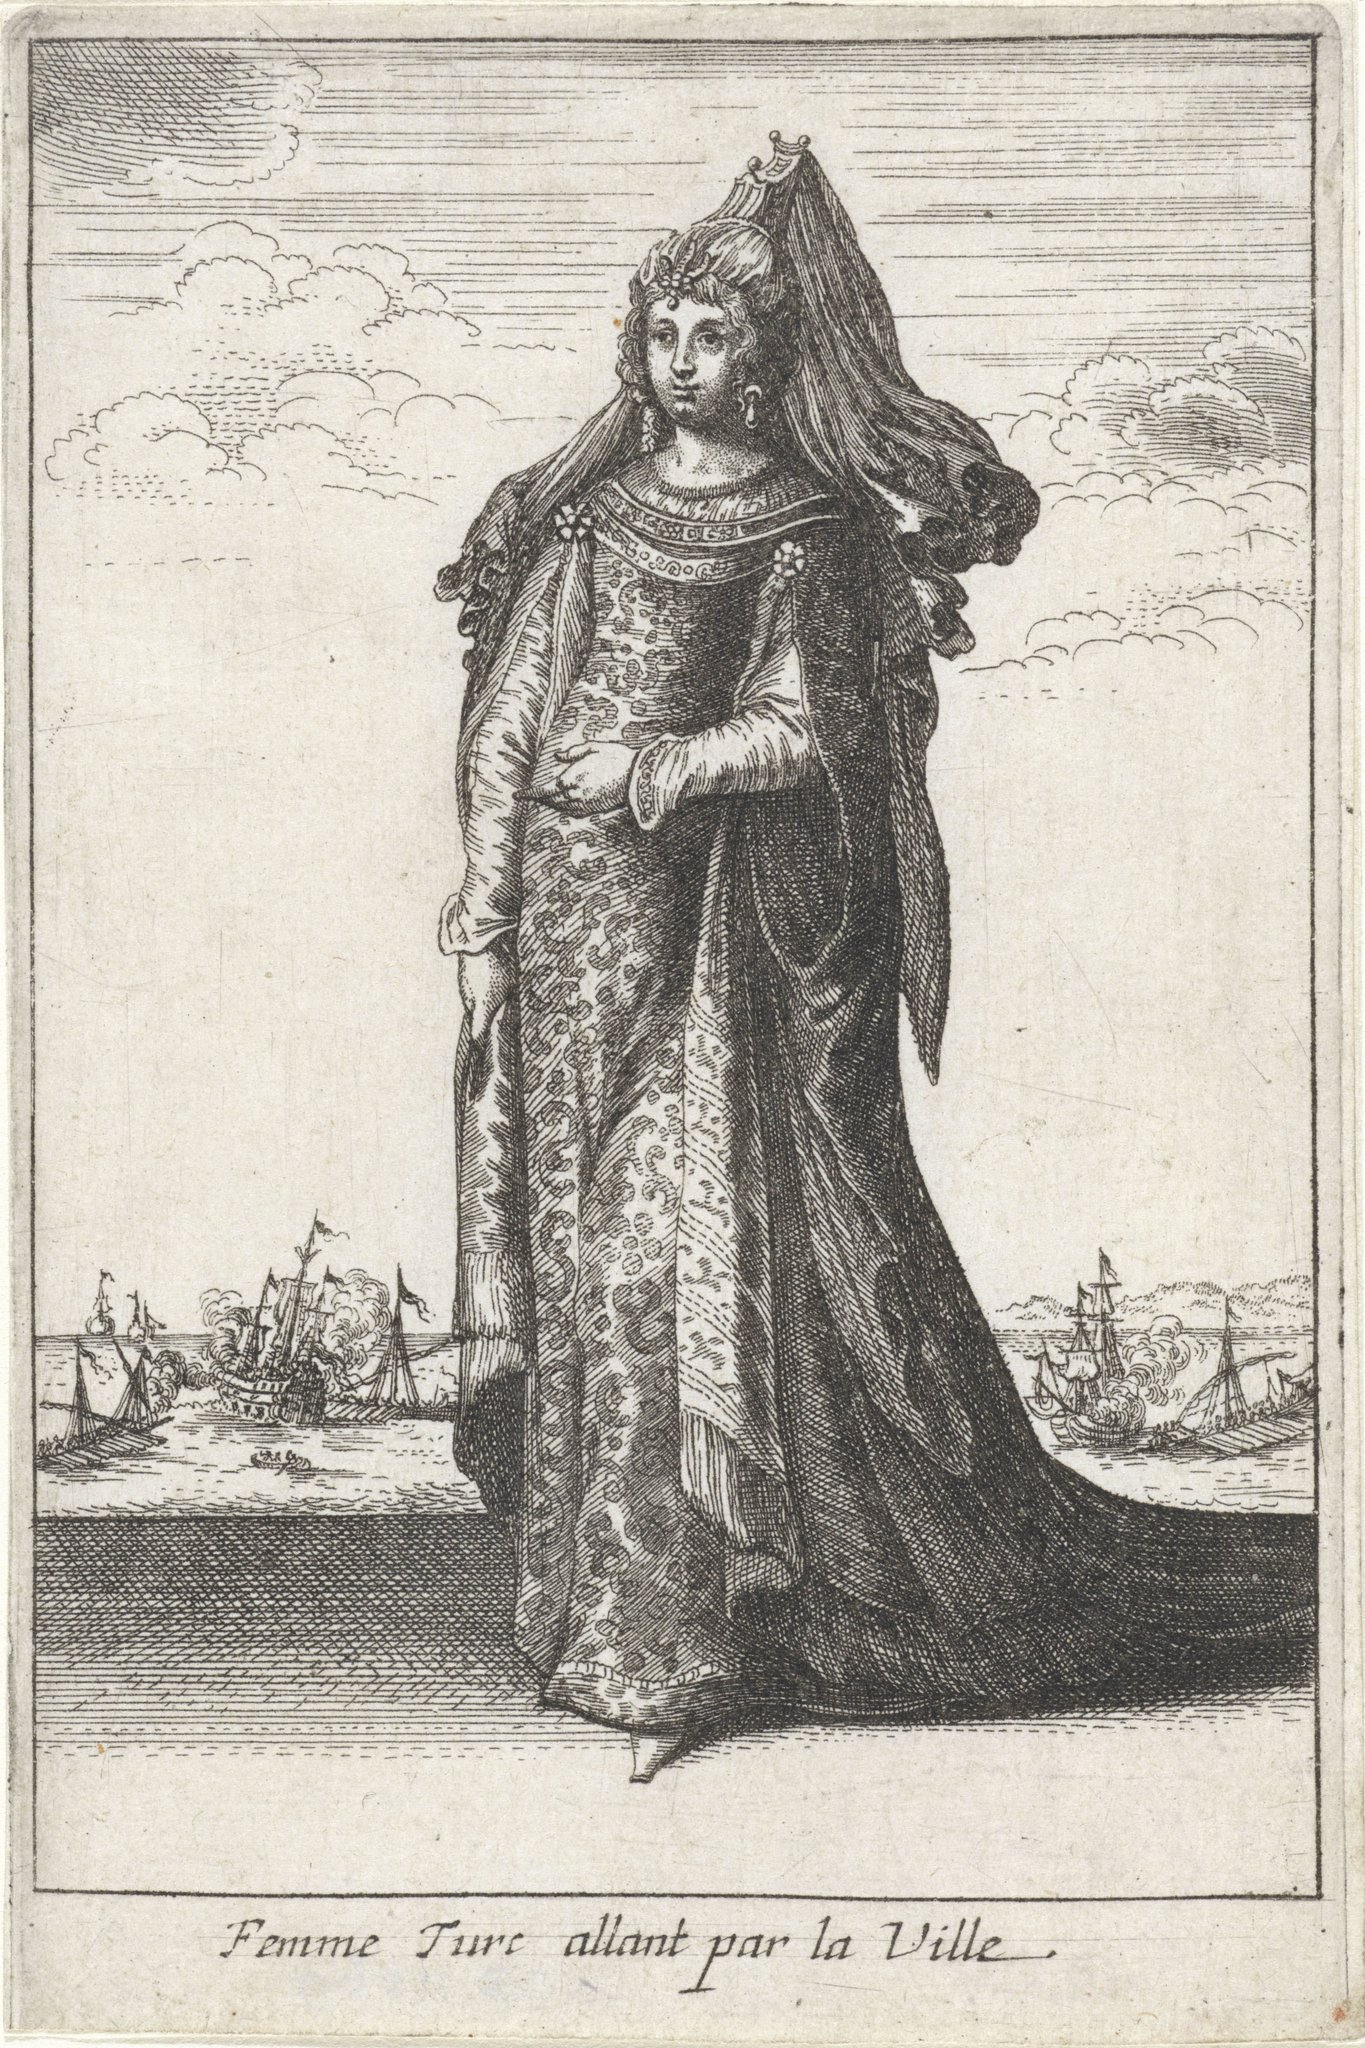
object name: costume print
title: Vrouwen in klederdracht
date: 1662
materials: paper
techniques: etching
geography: paris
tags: turkije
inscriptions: collector's mark: Lugt 240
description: Kopie naar prent die deel uitmaakt van de 50-delige serie met klederdracht van vrouwen uit verschillende landen. De prent maakt deel uit van de 28-delige serie (excl. titelprent) met voorstellingen van vrouwen in verschillende klederdrachten, getiteld "Livre curieux contenant la naifue representations des habits des femmes des diverses parties du Monde (...), 1662".